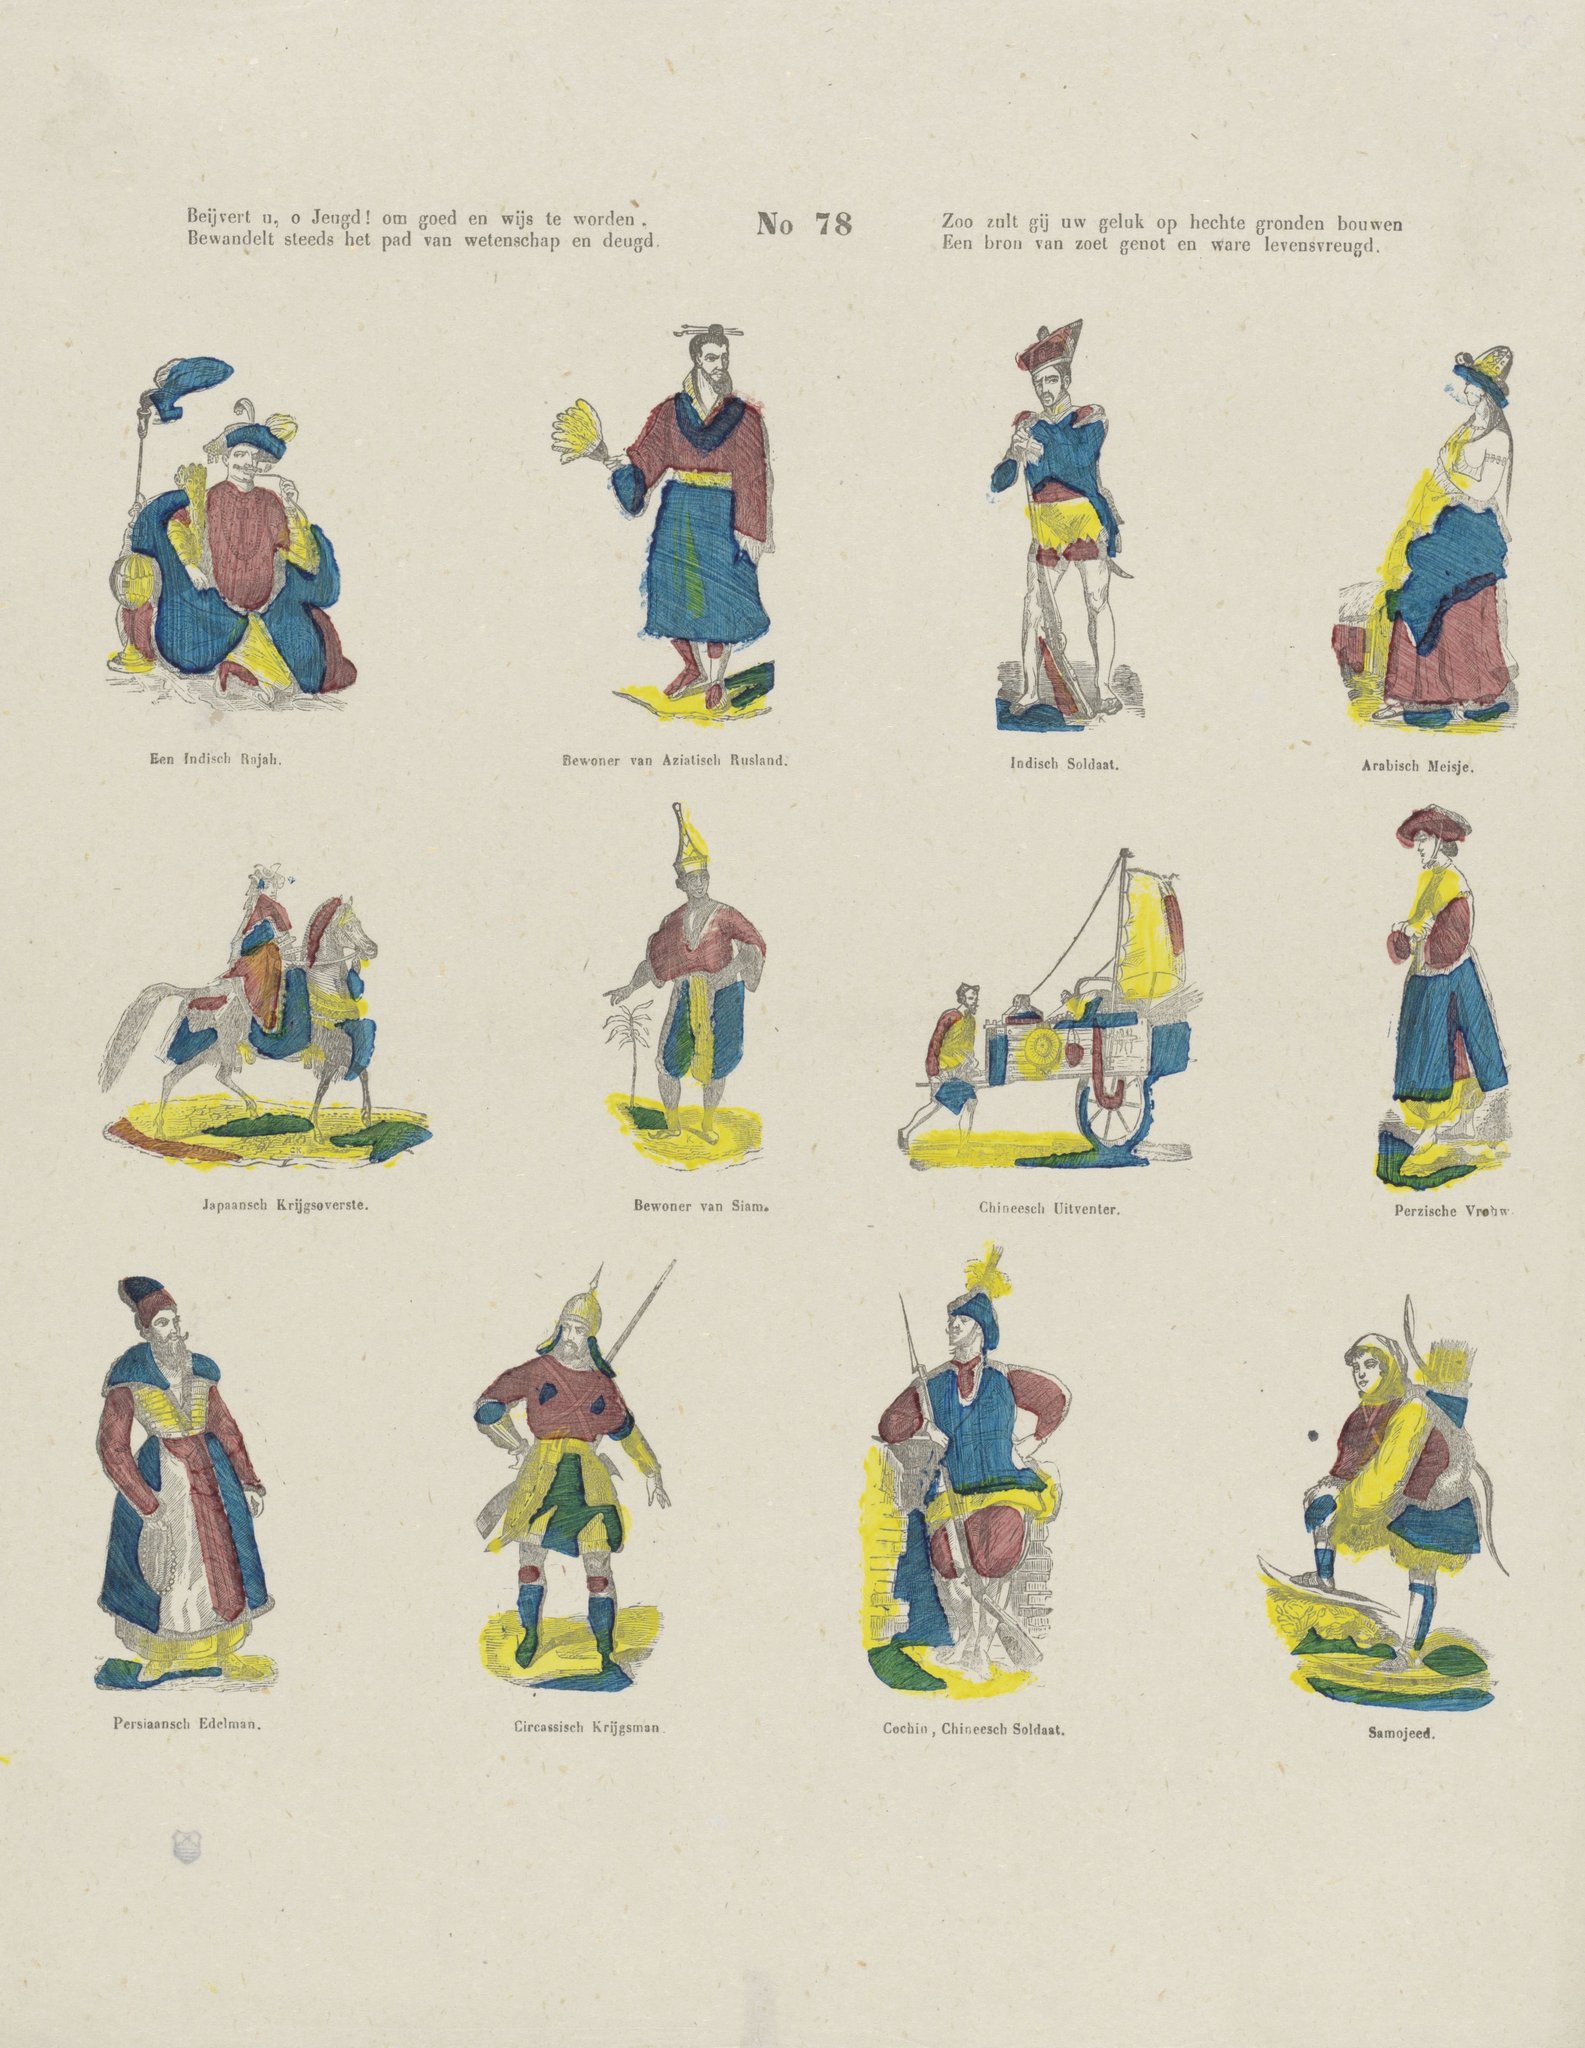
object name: print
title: Beijvert u, o jeugd! om goed en wijs te worden, / Bewandelt steeds het pad van wetenschap en deugd. / Zoo zult gij uw geluk op hechte gronden bouwen / Een bron van zoet genot en ware levensvreugd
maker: Anonymous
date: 1848-1881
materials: paper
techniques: colour, letterpress printing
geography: den bosch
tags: asiatic races and peoples, human types, characters (human types)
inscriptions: collector's mark: Lugt 2760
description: Blad met 12 voorstellingen van verschillende figuren uit het Oosten. Onder elke afbeelding een onderschrift. Genummerd midden boven: No. 78.